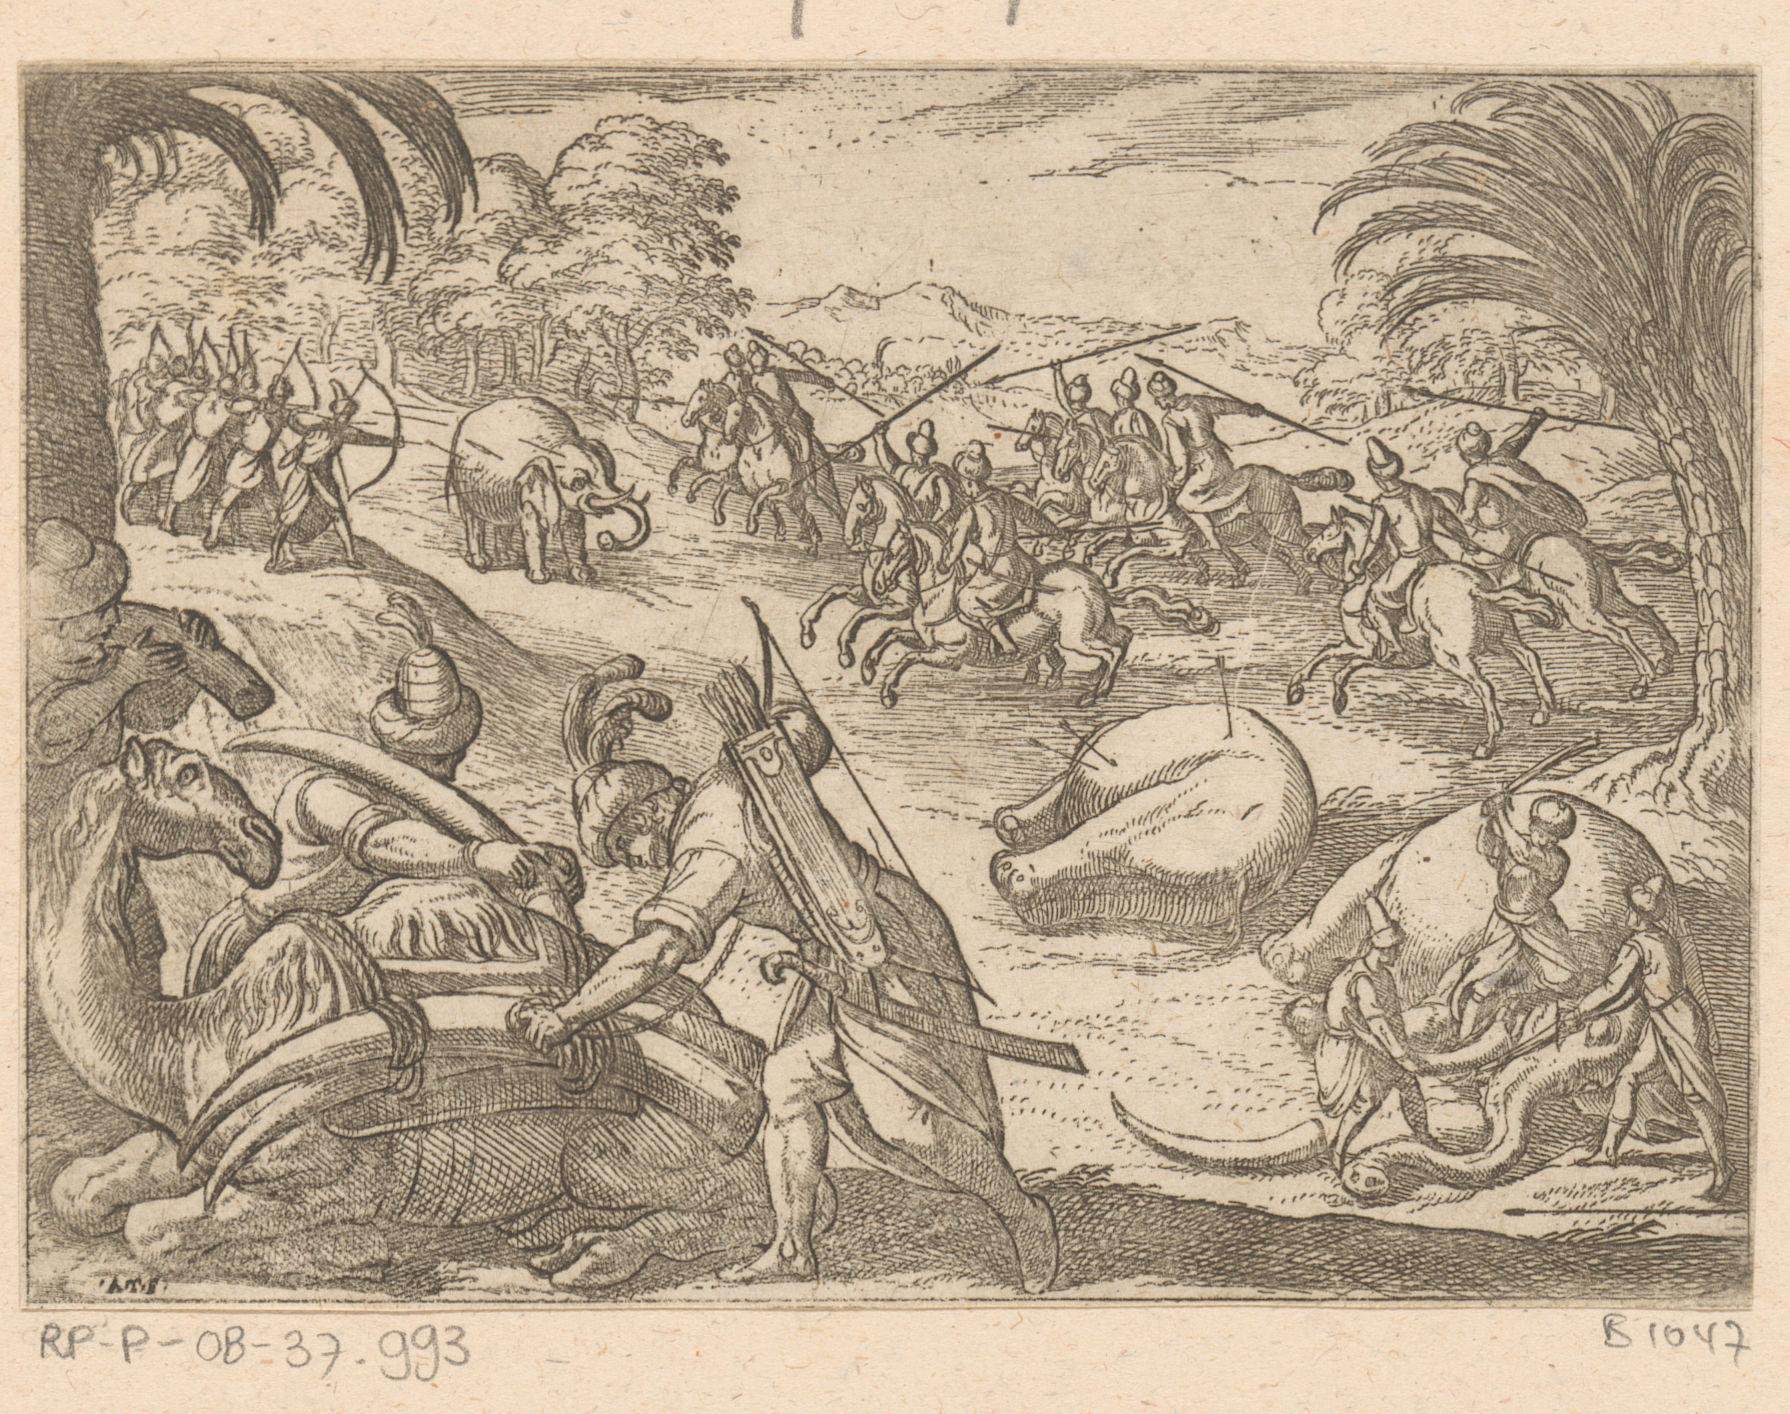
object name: print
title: Primo libro di caccie varie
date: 1598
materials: paper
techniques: etching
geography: italy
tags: hunter, hunters hunting (n.b.: in 1988-1990 this notation denoted the concept of 43c11421 'hunters resting during the hunt'), hunt ~ mammals, trunked animals: elephant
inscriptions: collector's mark: Lugt 2165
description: Landschap met jagers jagend op olifanten. Op de voorgrond links mannen die slagtanden van dode olifanten op een dromedaris laden. Op de voorgrond rechts hakken mannen de slagtanden van een dode olifant af.